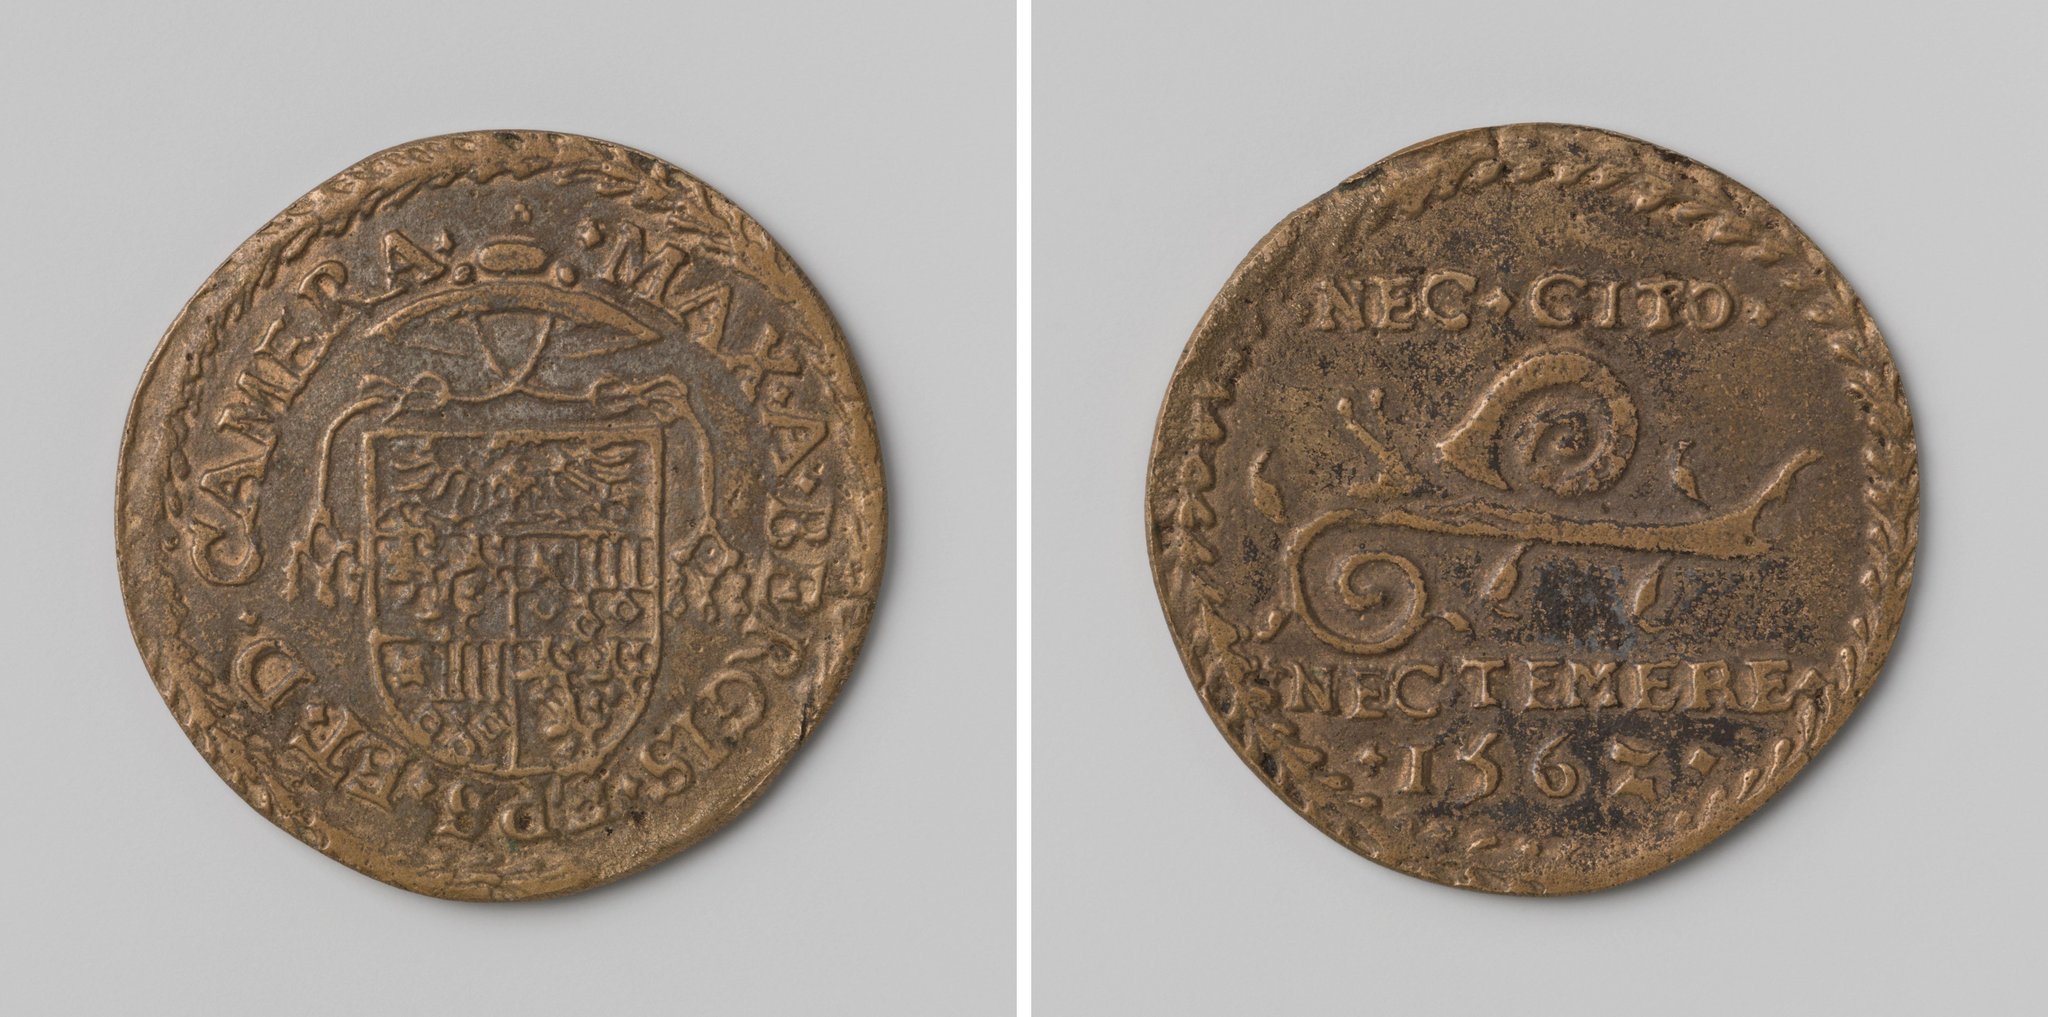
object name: jeton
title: Maximiliaan van Bergen, aartsbisschop van Kamerijk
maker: Anonymous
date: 1562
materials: copper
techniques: striking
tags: aartsbisschop van kamerijk maximiliaan van bergen, cambrai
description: Koperen penning. Voorzijde: wapenschild onder kardinaalshoed binnen omschrift en lauwerkrans. Keerzijde: slak, kruipend op blad onder en boven opschrift binnen lauwerkrans